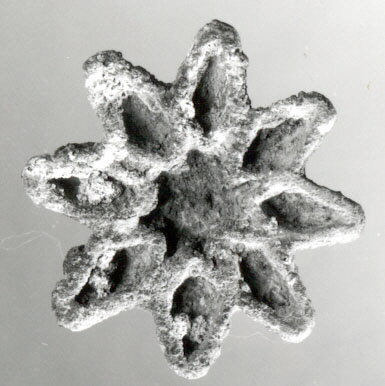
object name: stamp seal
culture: bactria-margiana archaeological complex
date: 2333-1668 BCE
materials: copper alloy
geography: bactria-margiana